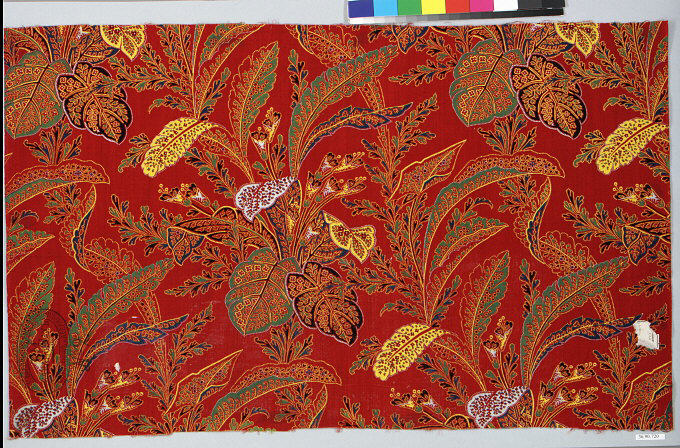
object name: piece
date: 1867-1900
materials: cotton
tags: leaves